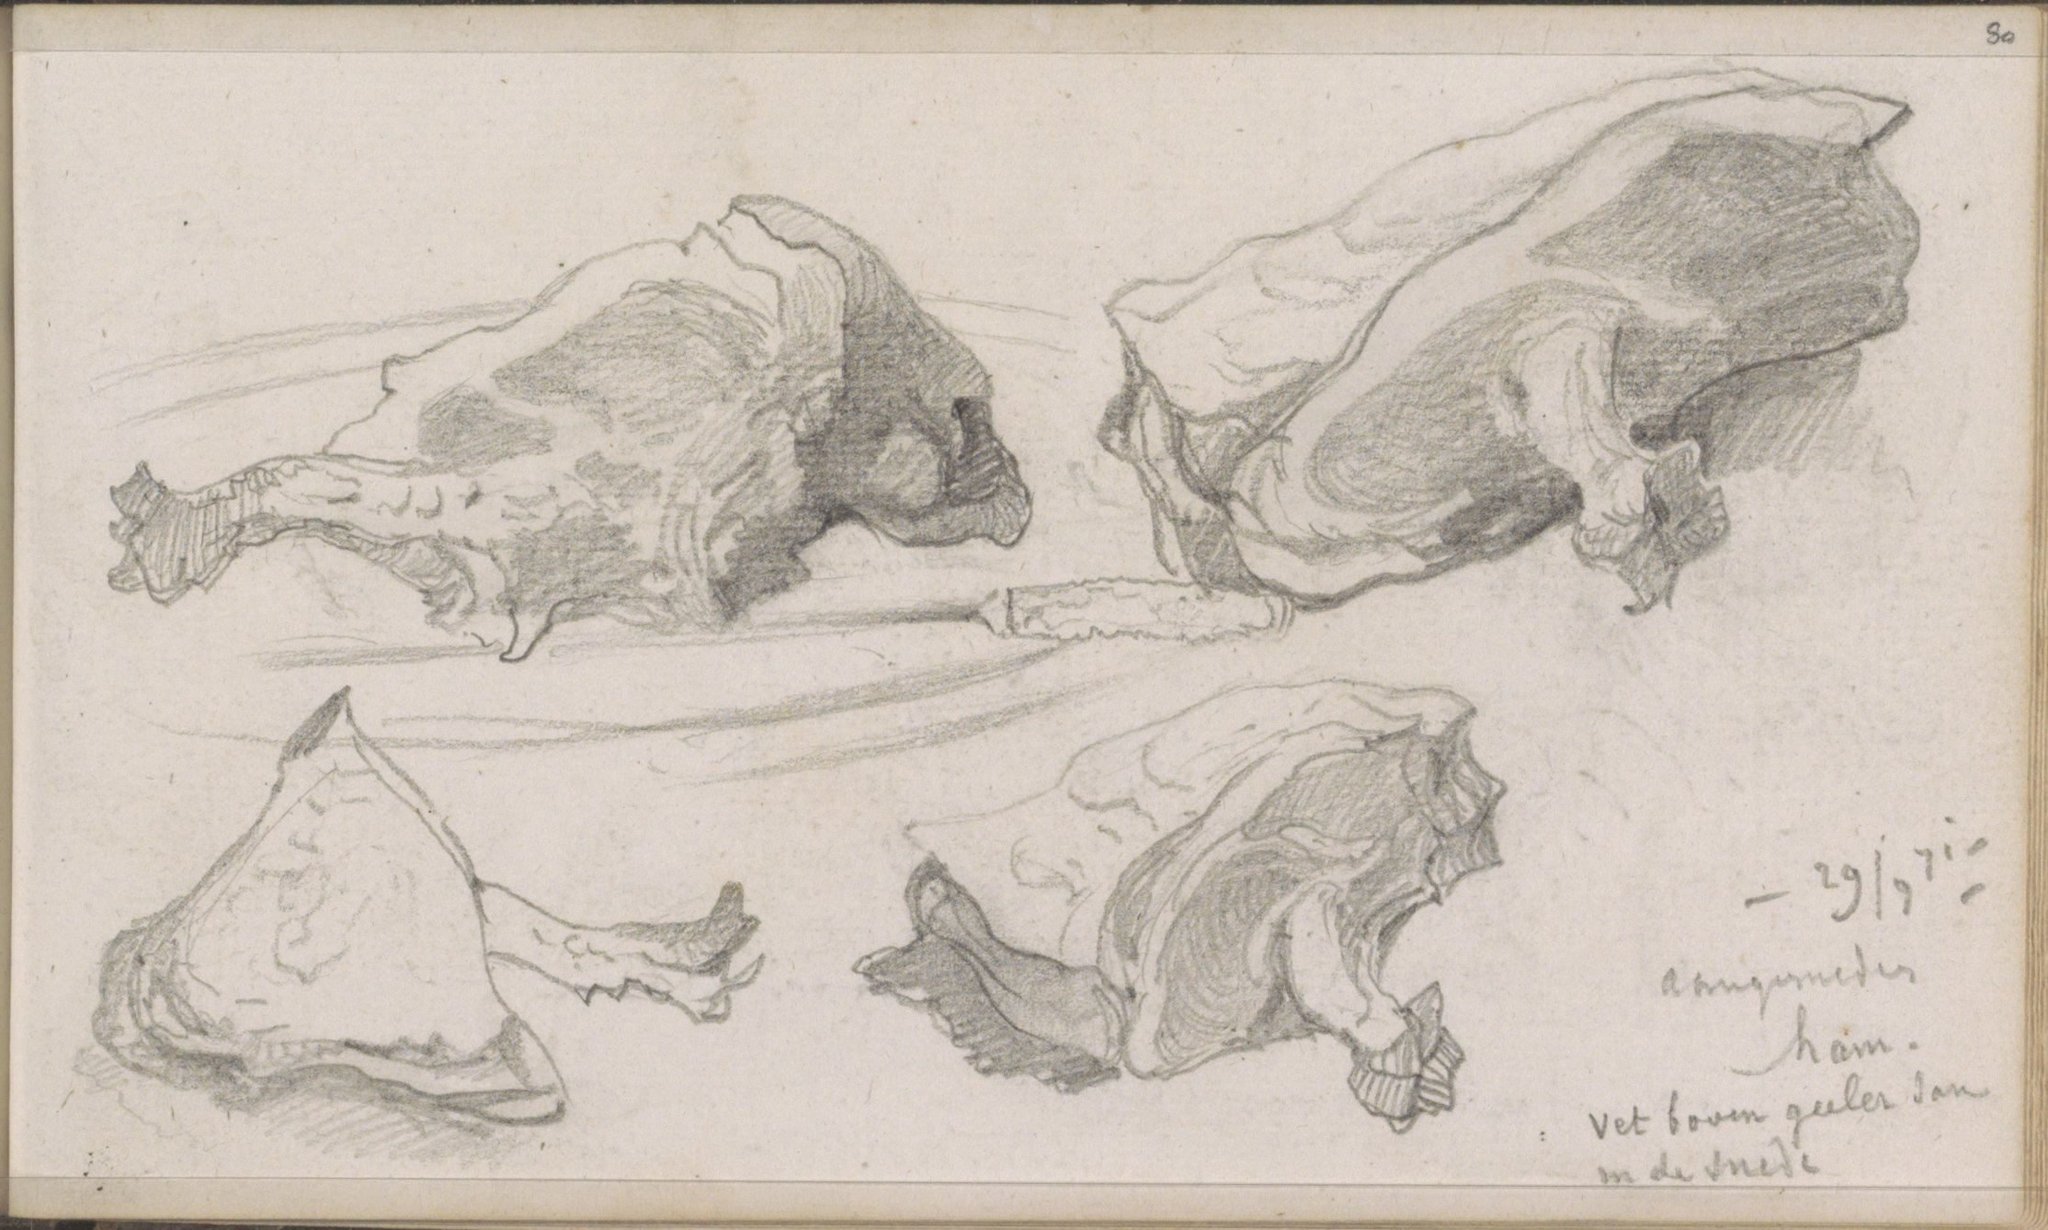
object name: sketchbook leaf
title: Stukken ham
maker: johannes tavenraat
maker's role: draughtsman, painter, print maker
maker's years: 1809-1881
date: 1809-1871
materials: paper, pencil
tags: ham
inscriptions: date and inscription: ‘29/9 71/ [...]gesneden/ ham./ vet boven geeler dan/ in de snede’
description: Blad 80 recto uit een schetsboek met 98 bladen.